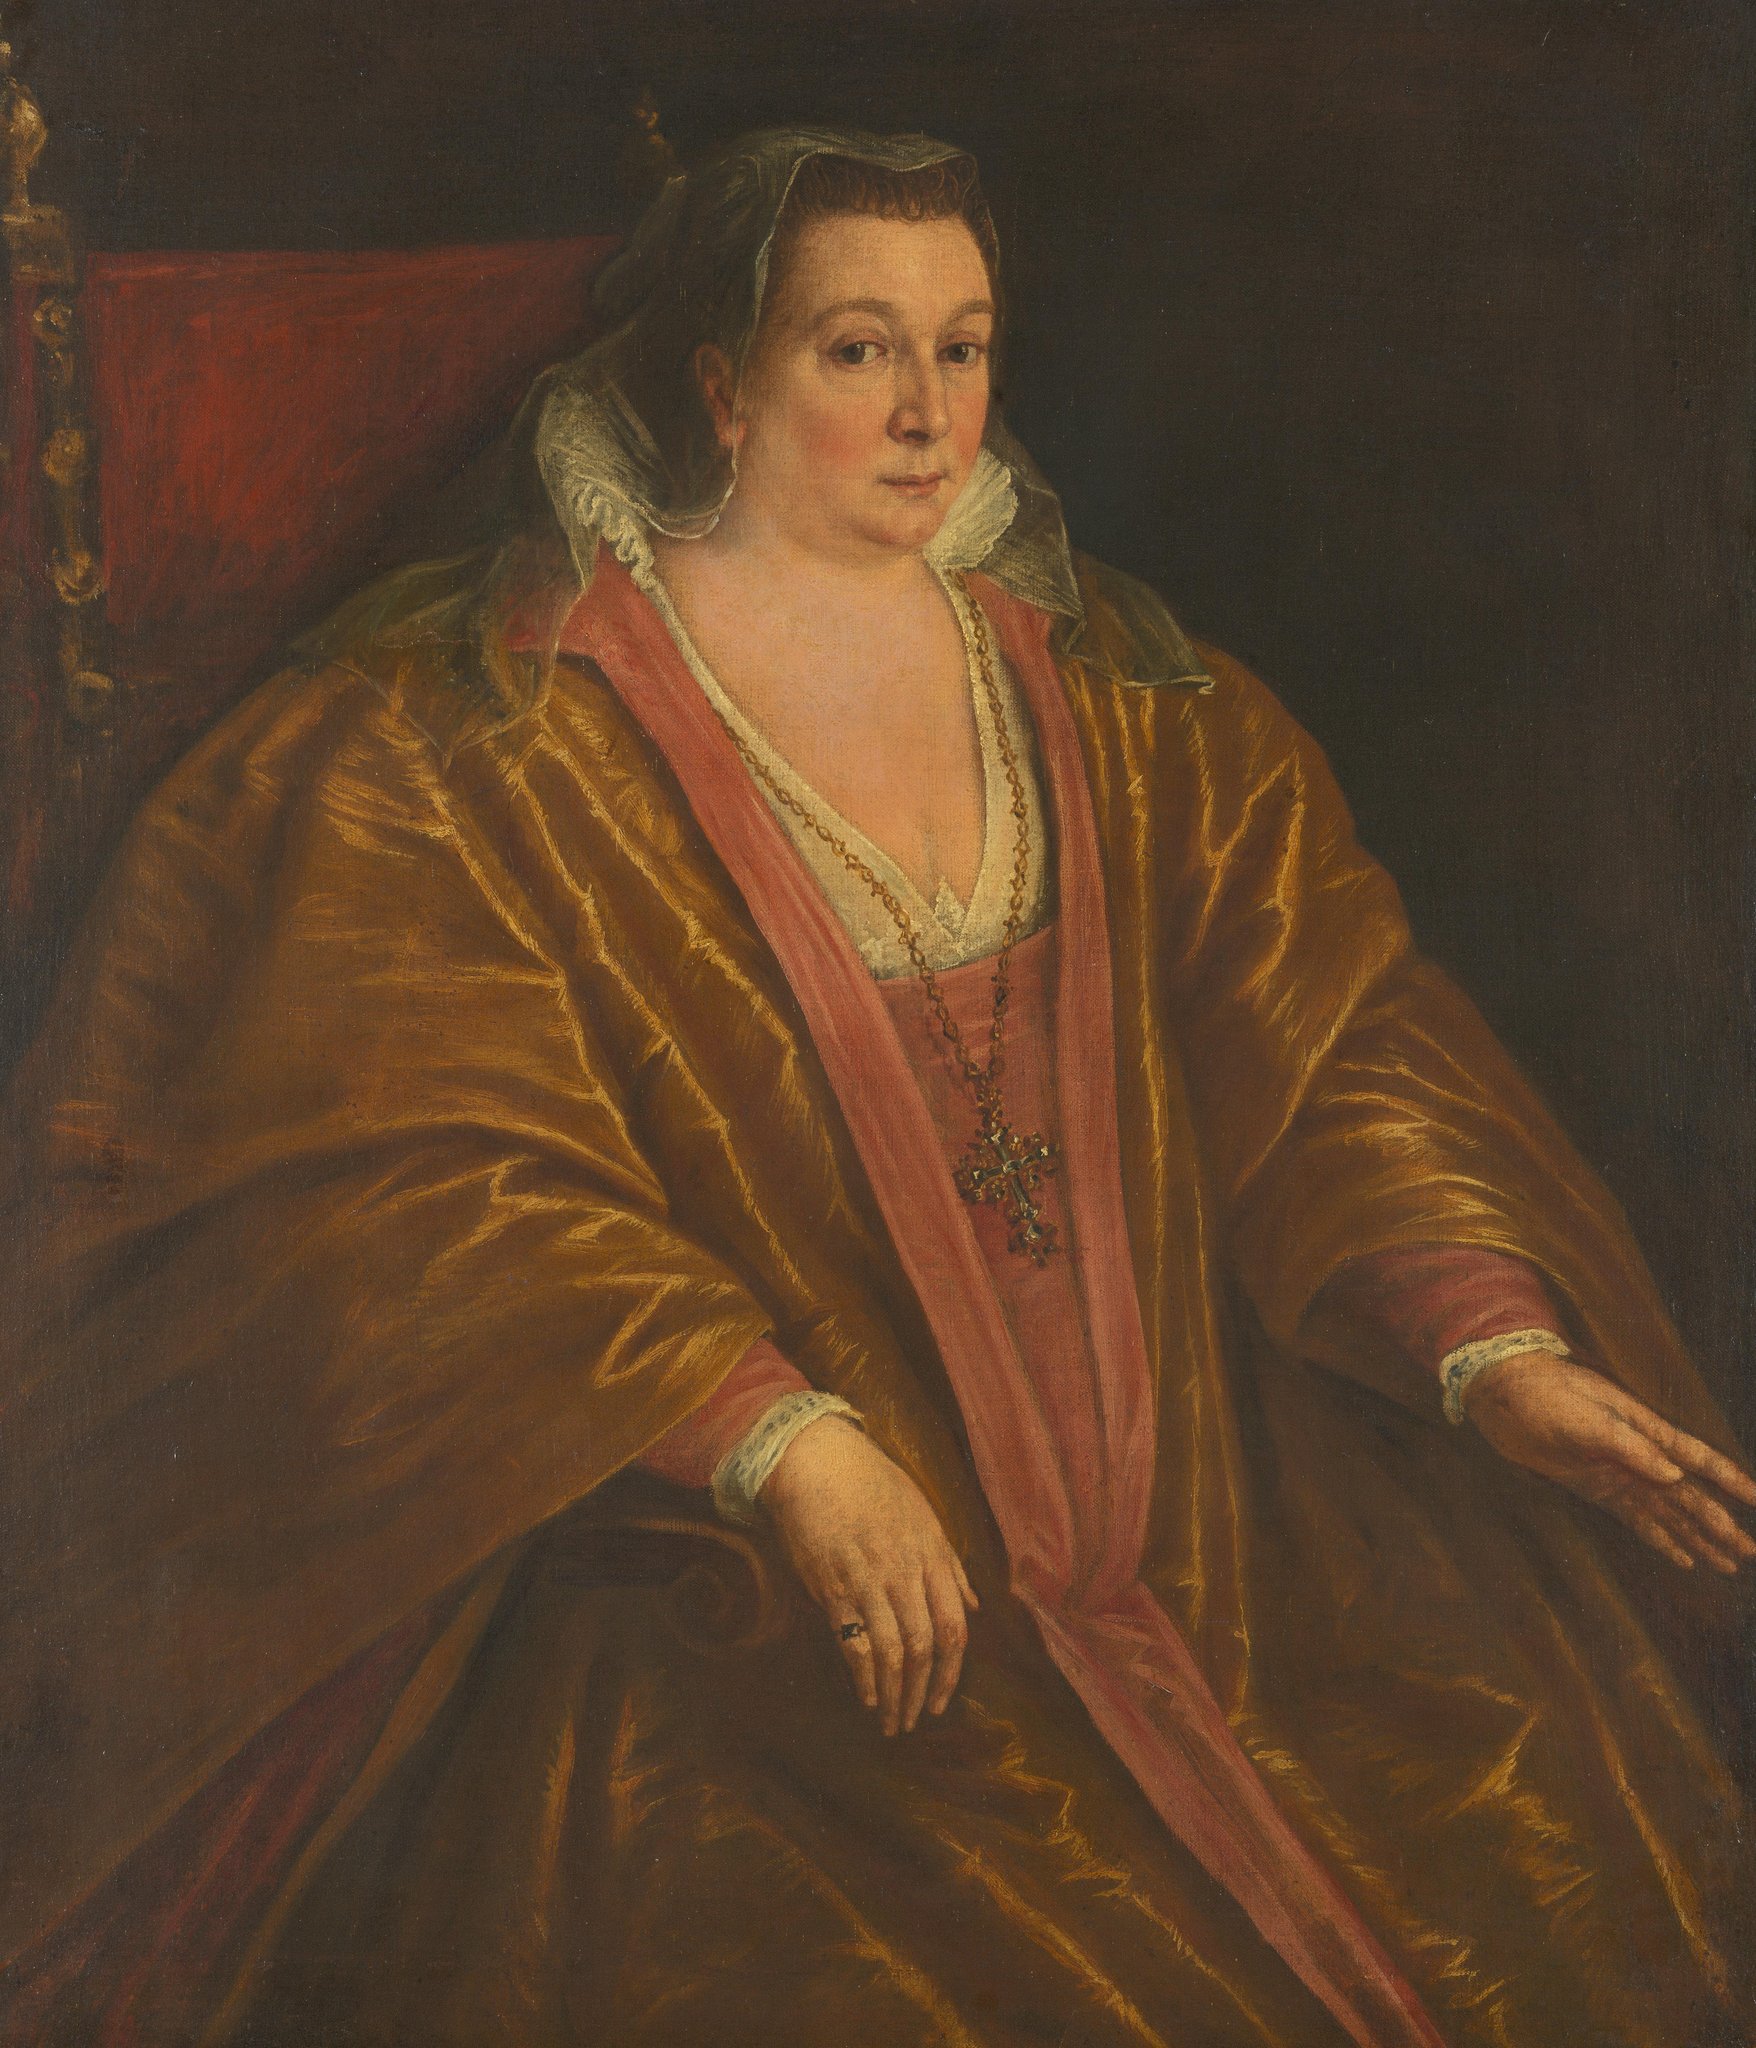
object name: painting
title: Portrait of a Woman, probably Morosina Morosini, Wife of Marino Grimani, the Doge of Venice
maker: leandro bassano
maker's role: draughtsman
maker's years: 1557-1622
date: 1590-1600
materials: canvas, oil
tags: historical persons - bb - woman, venice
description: Portret van een vrouw, waarschijnlijk Morosina Morosini, de echtgenote van Marino Grimani, doge van Venetië (in 1595). Kniestuk, zittend in een stoel.